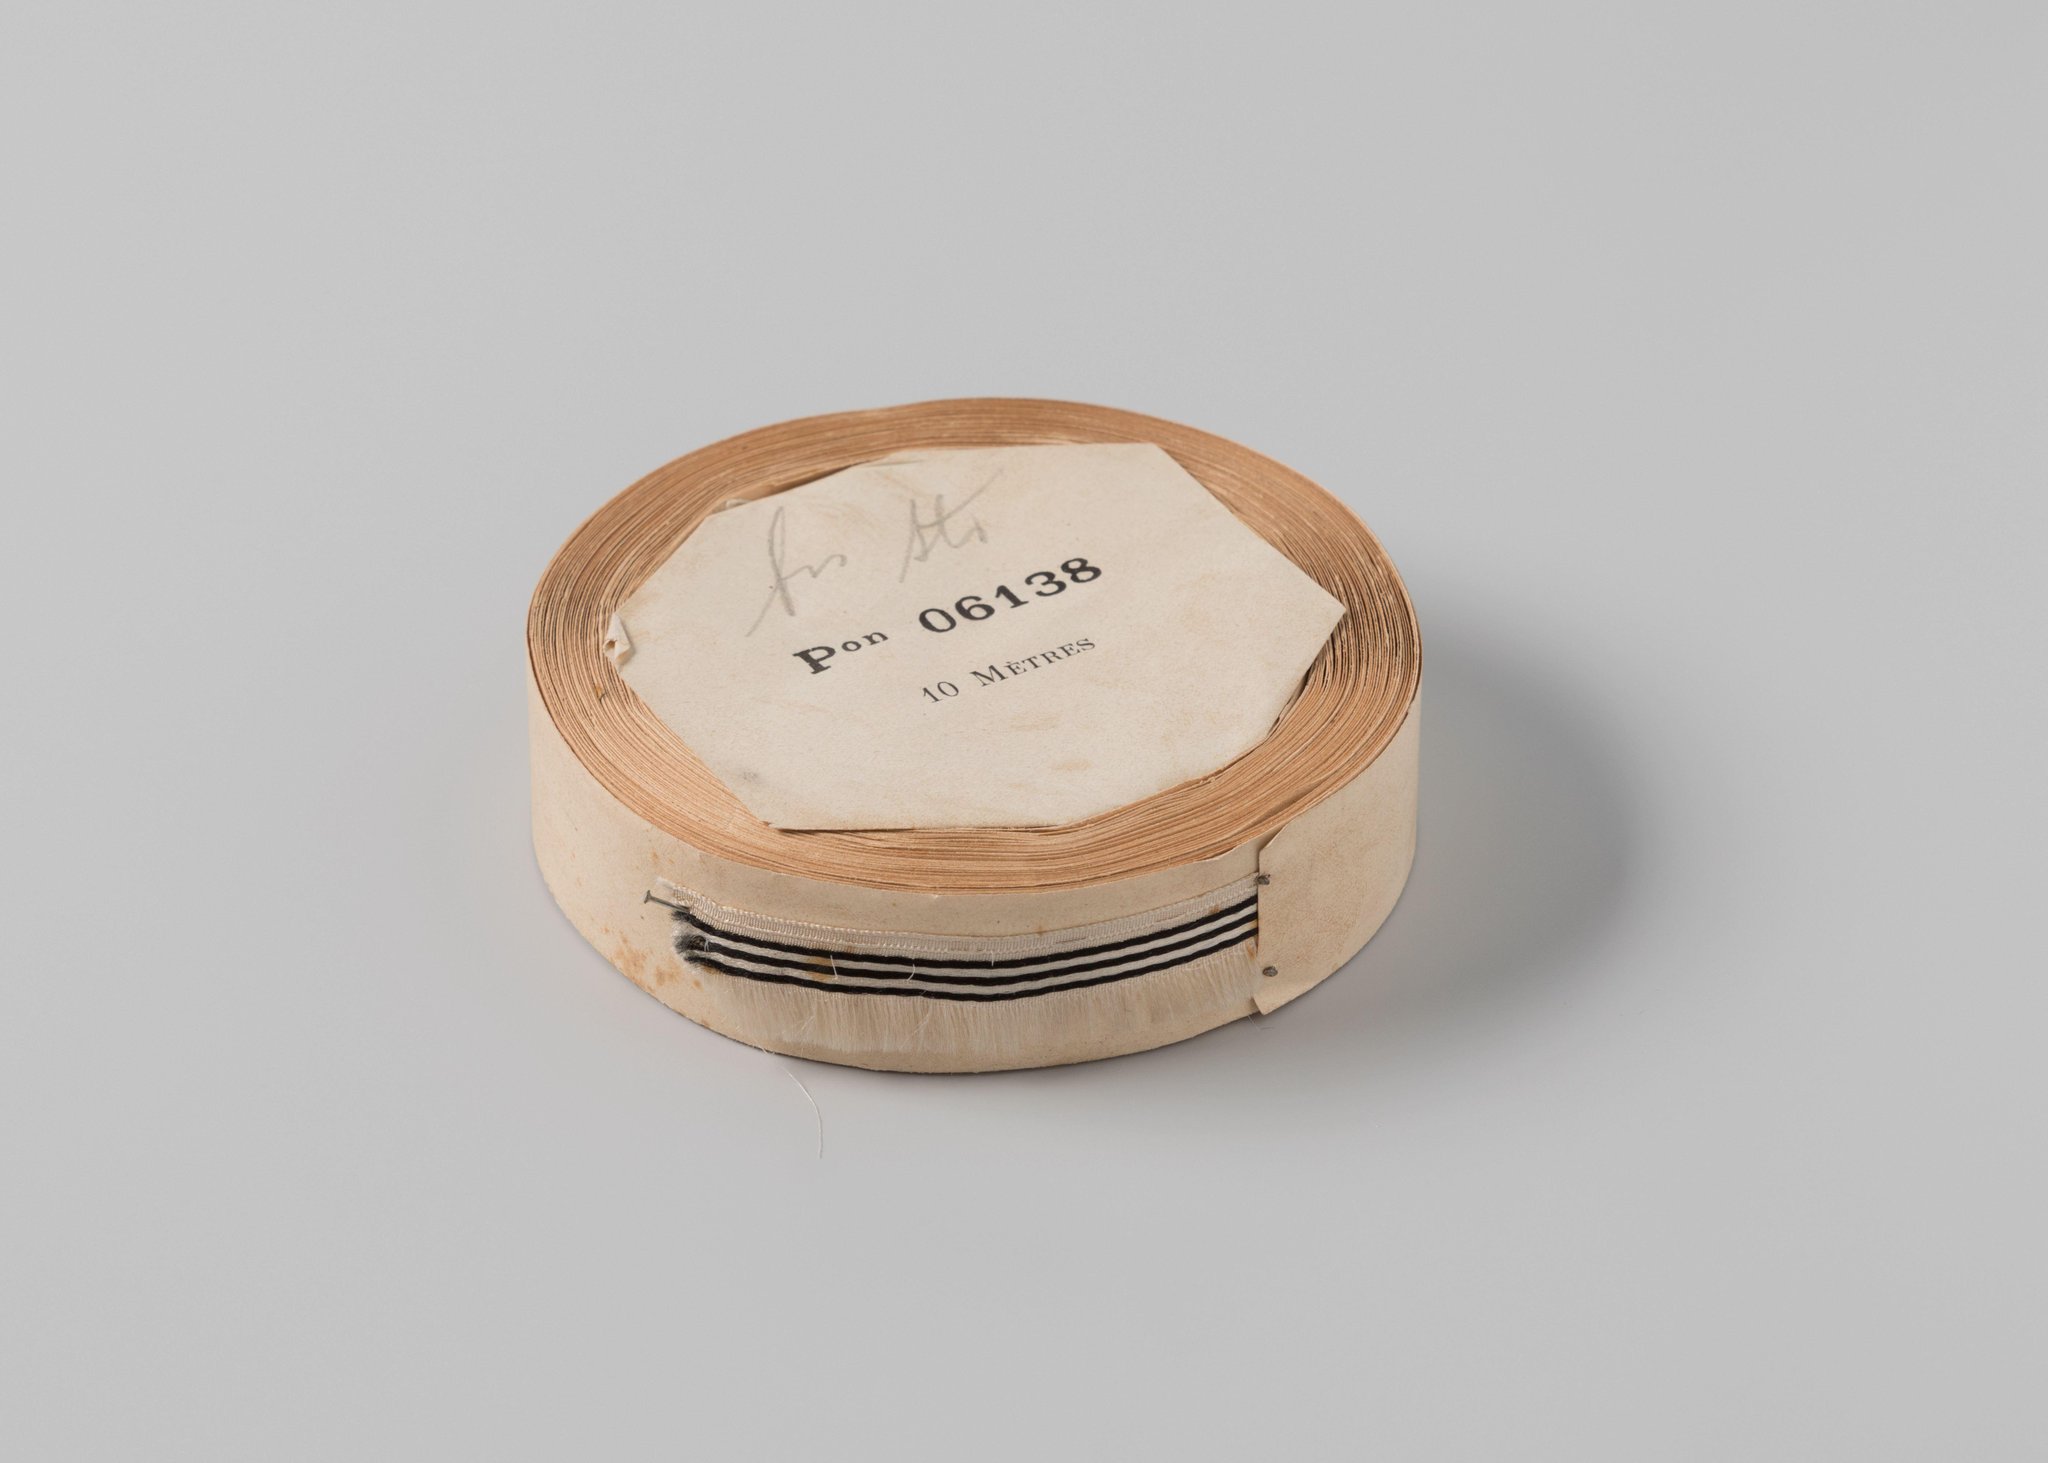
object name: rol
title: Rol met wit lint met één gerafelde zijde en drie zwarte horizontale strepen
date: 1930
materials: cardboard, paper, textile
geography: france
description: Rol met wit lint met één gerafelde zijde en drie zwarte horizontale strepen.